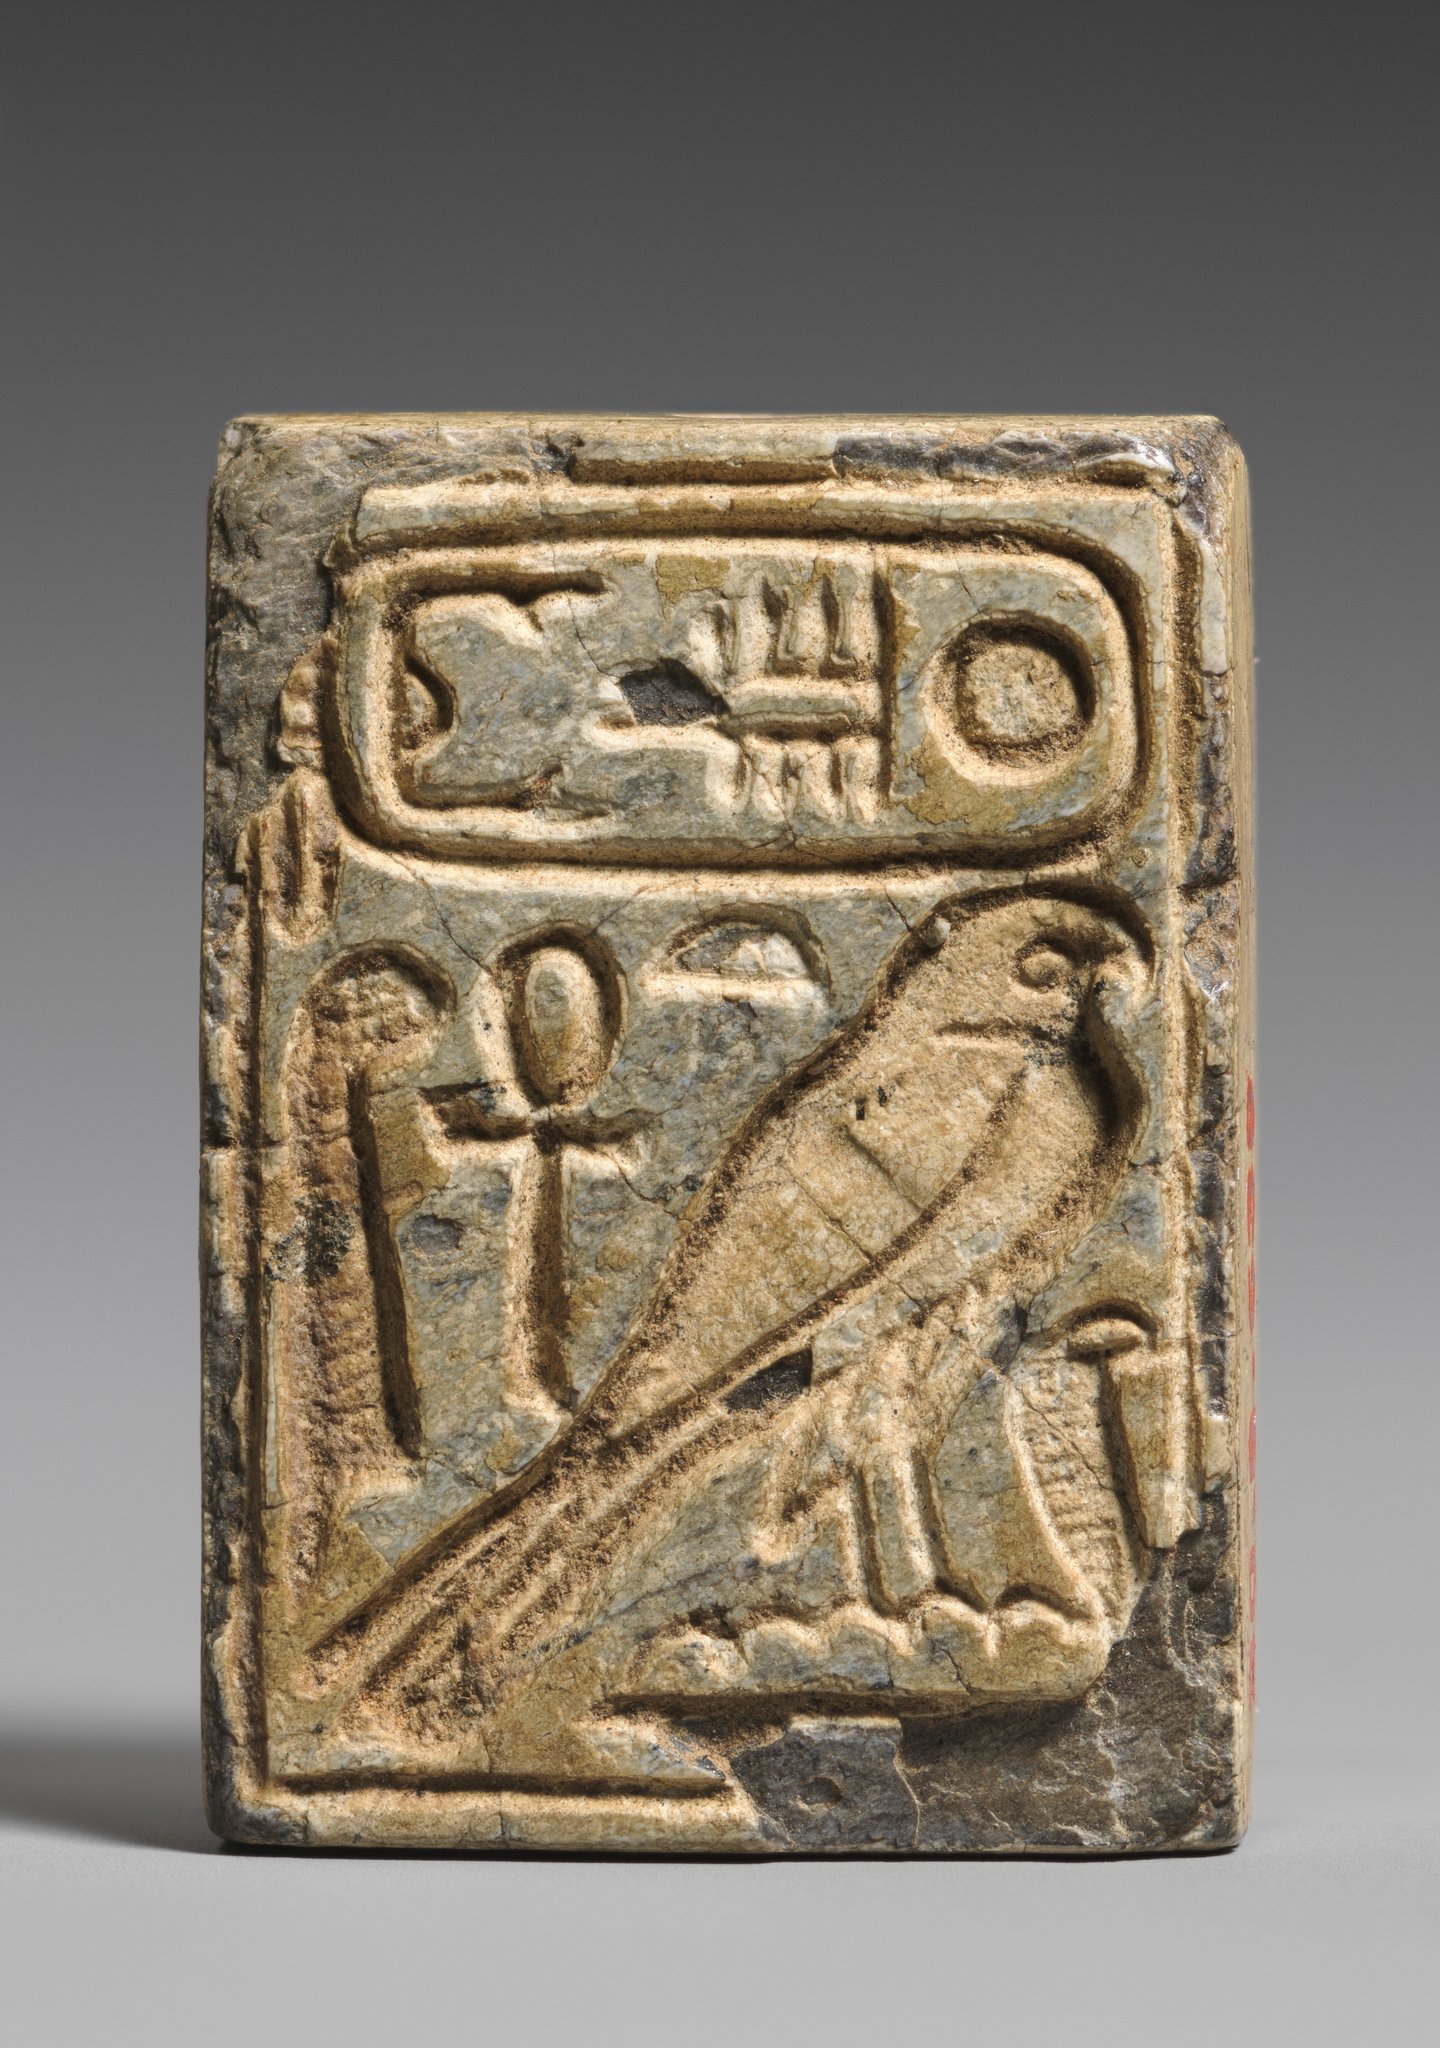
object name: plaque, shebitqo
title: Plaque with the throne name (Djedkare) of Shebitqo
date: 707-690 BCE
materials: faience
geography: nubia